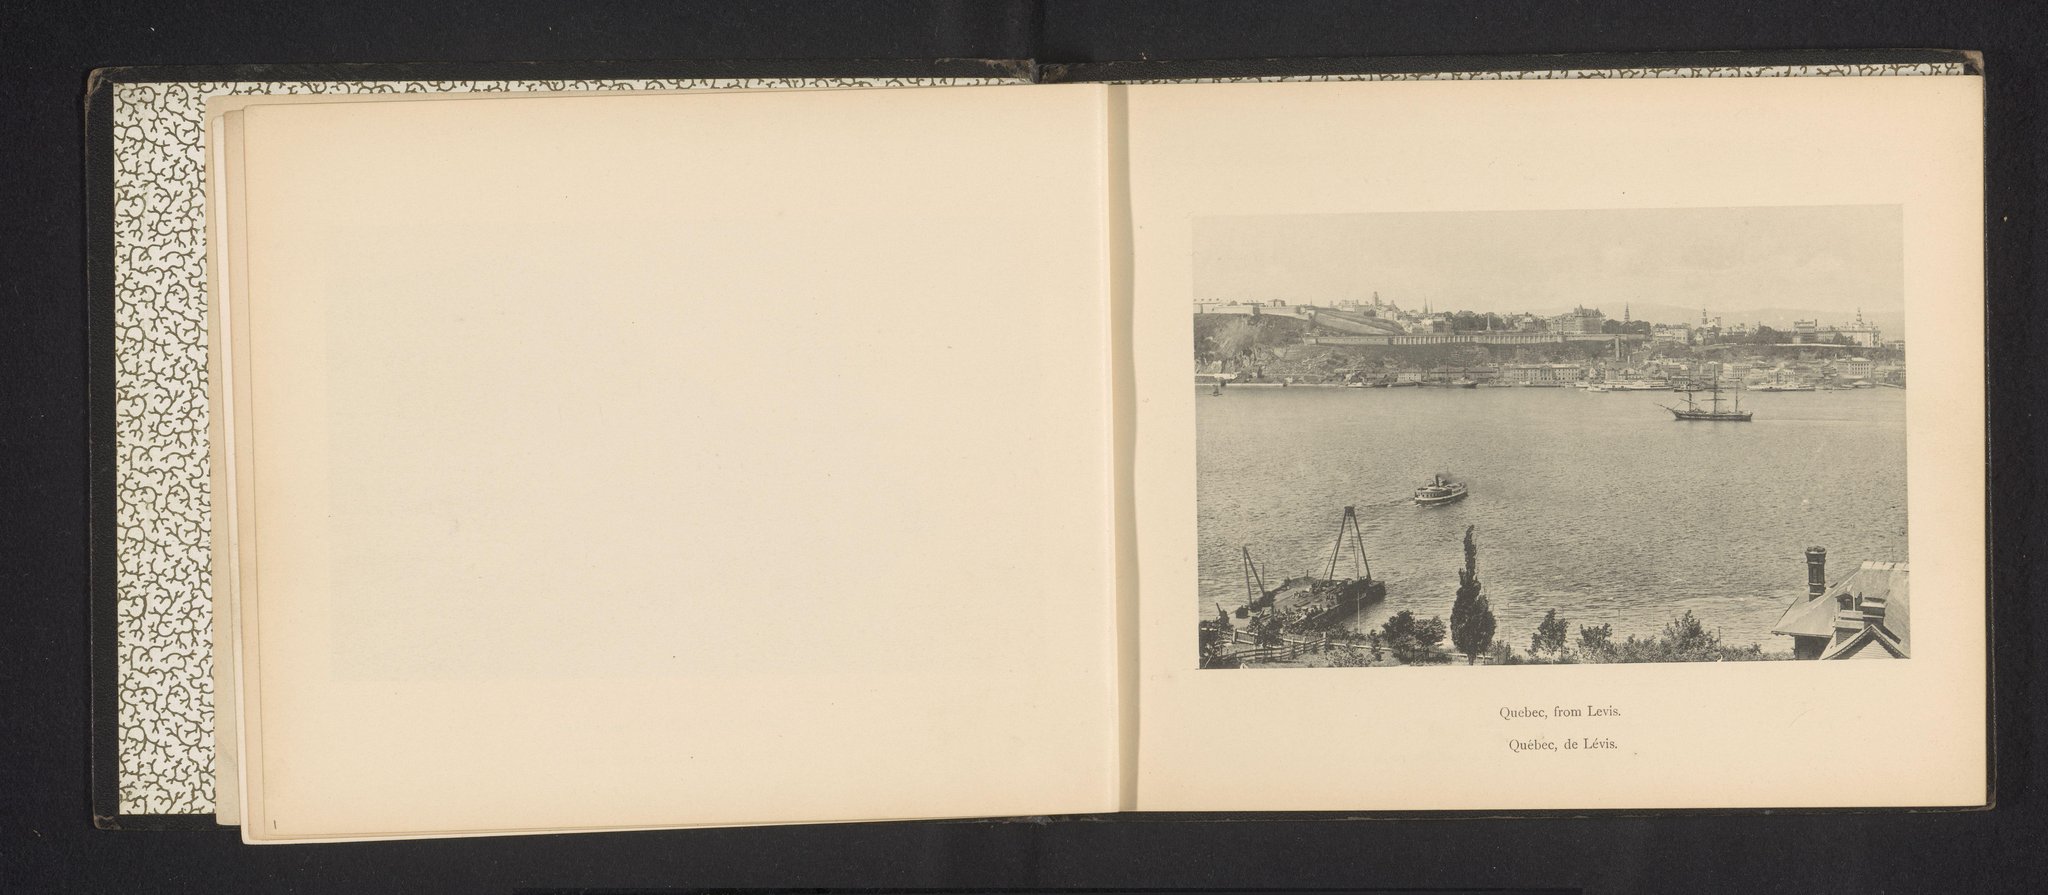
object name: page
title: Québec, from Levis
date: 1889-1894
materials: paper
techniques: photograph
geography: levis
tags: city-view in general; 'veduta', river, québec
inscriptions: inscription: ‘Québec, de Lévis’